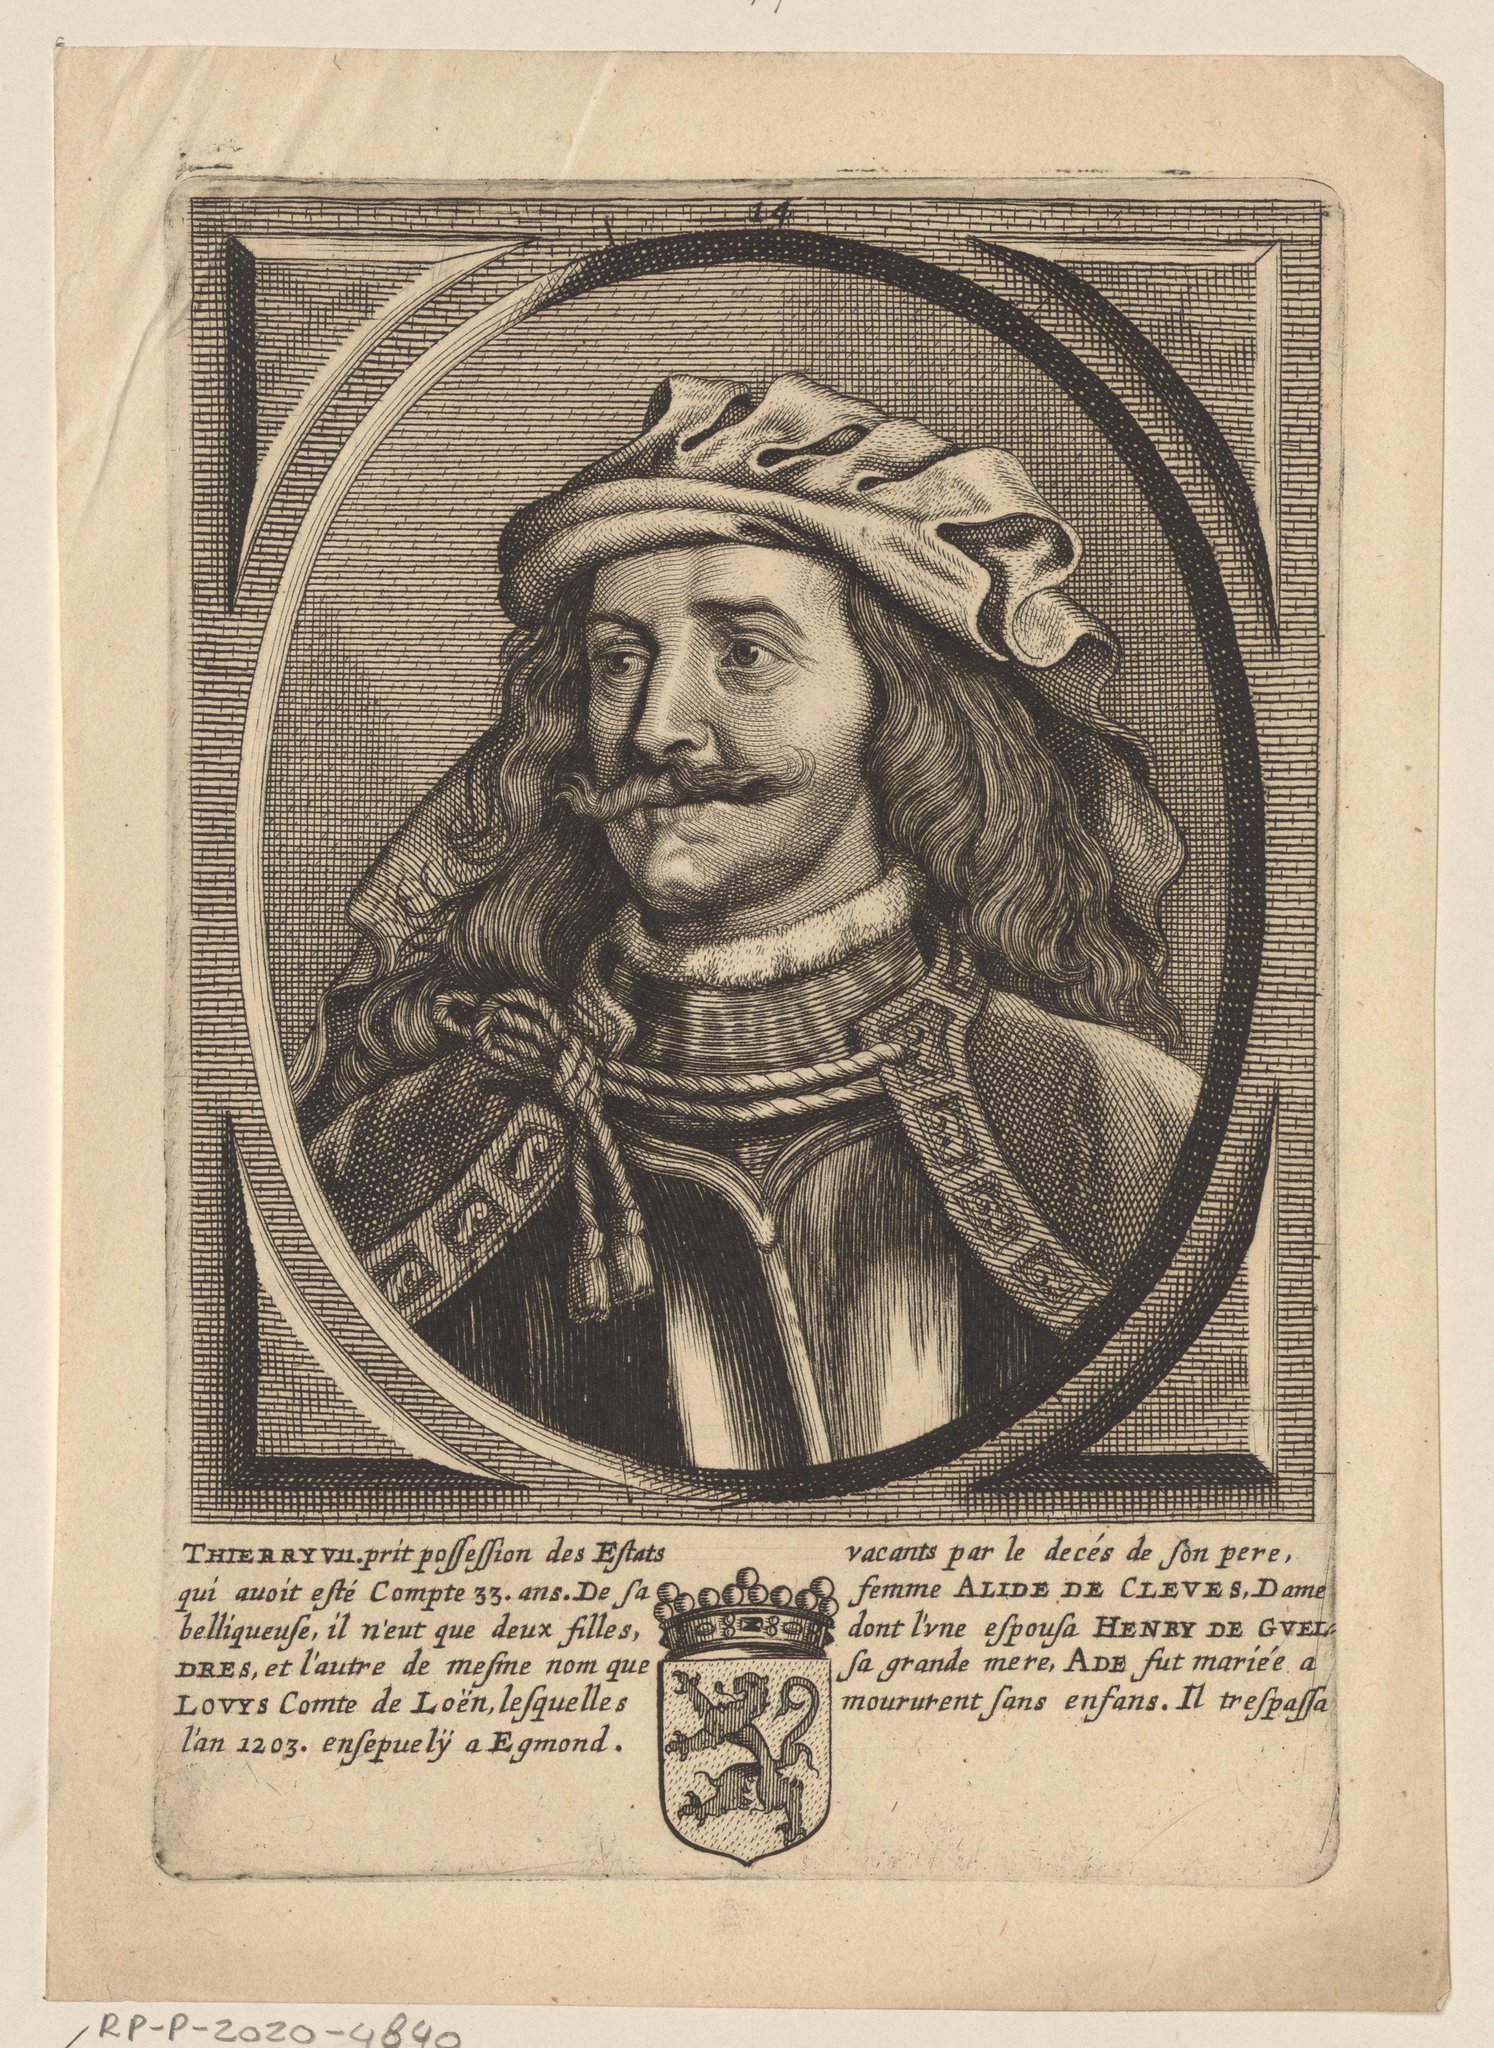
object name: print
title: Les pourtraits des souverains princes et comtes de Hollande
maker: cornelis meyssens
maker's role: print maker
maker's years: 1640-1673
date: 1662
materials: paper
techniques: engraving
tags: historical persons, head-gear: hat, ruler, sovereign, armorial bearing, heraldry